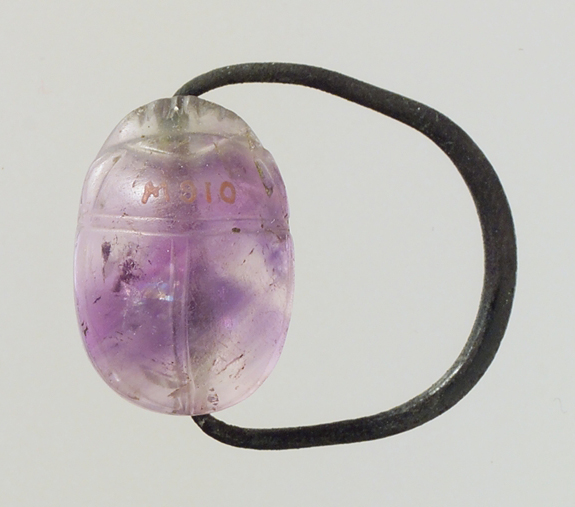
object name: ring with scarab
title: Scarab Finger Ring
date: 1981-1802 BCE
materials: gemstone, copper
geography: egypt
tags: scarabs